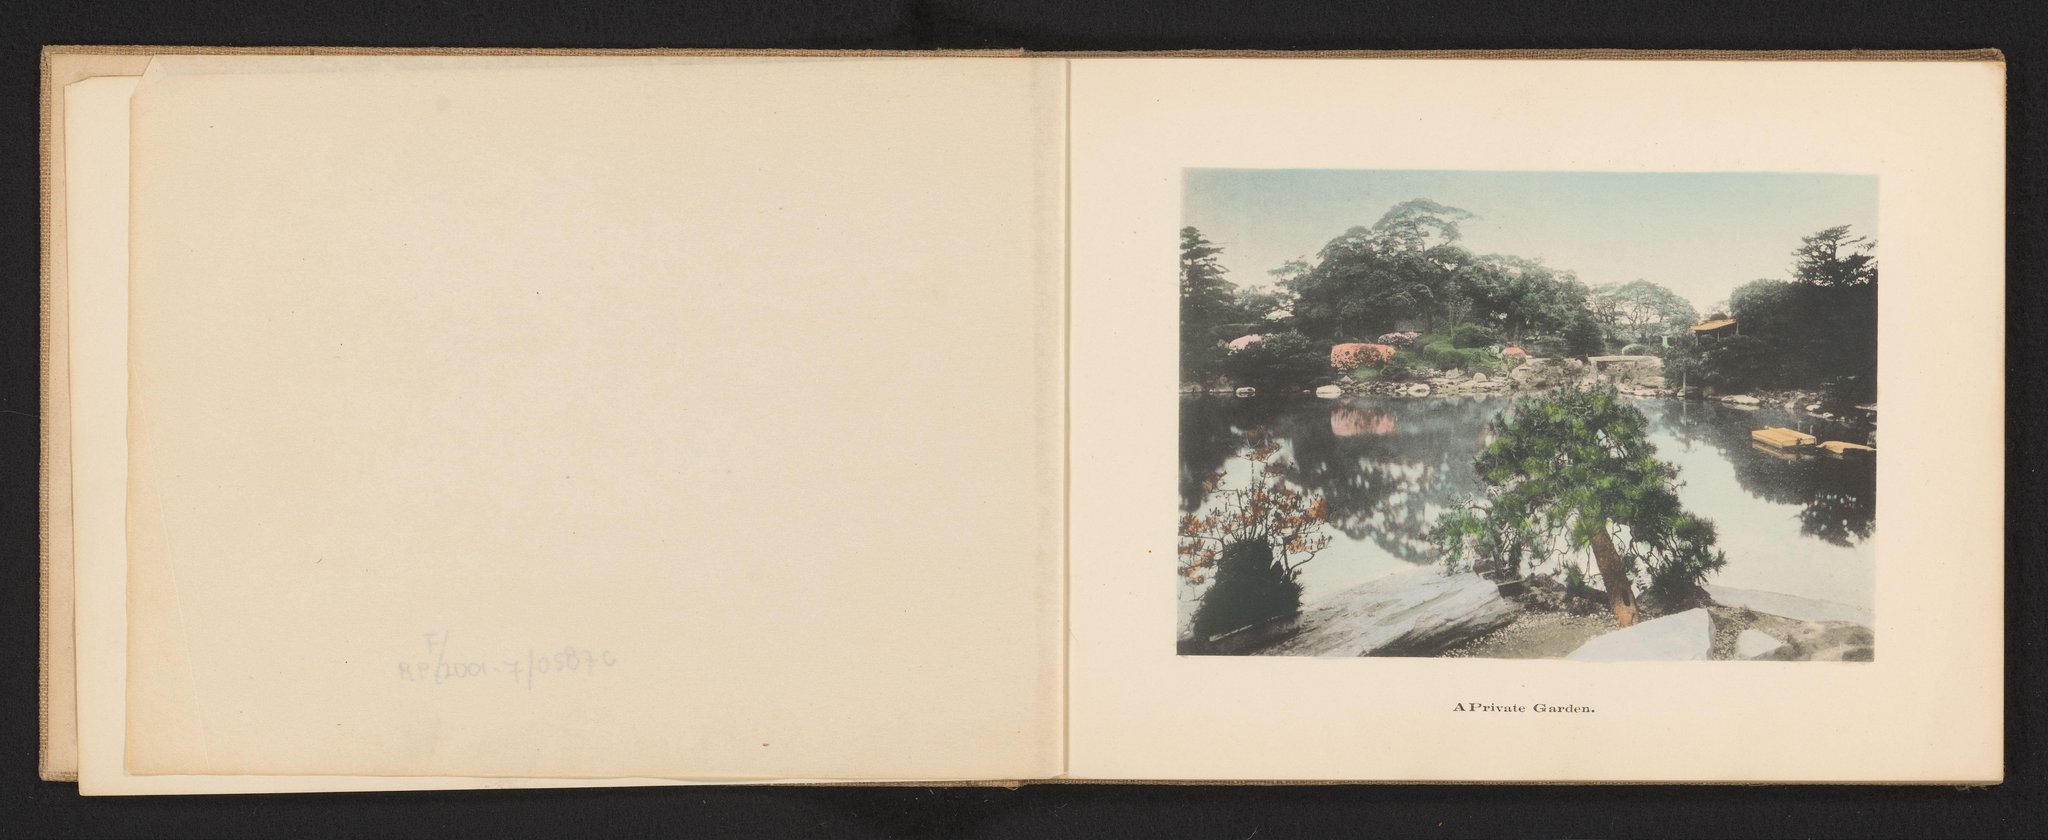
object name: page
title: Gezicht op een tuin met een vijver in Japan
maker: kōzaburō tamamura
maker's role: fotograaf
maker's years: 1856-1923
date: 1895-1905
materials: paper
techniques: photograph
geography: japan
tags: garden, garden pond, japan